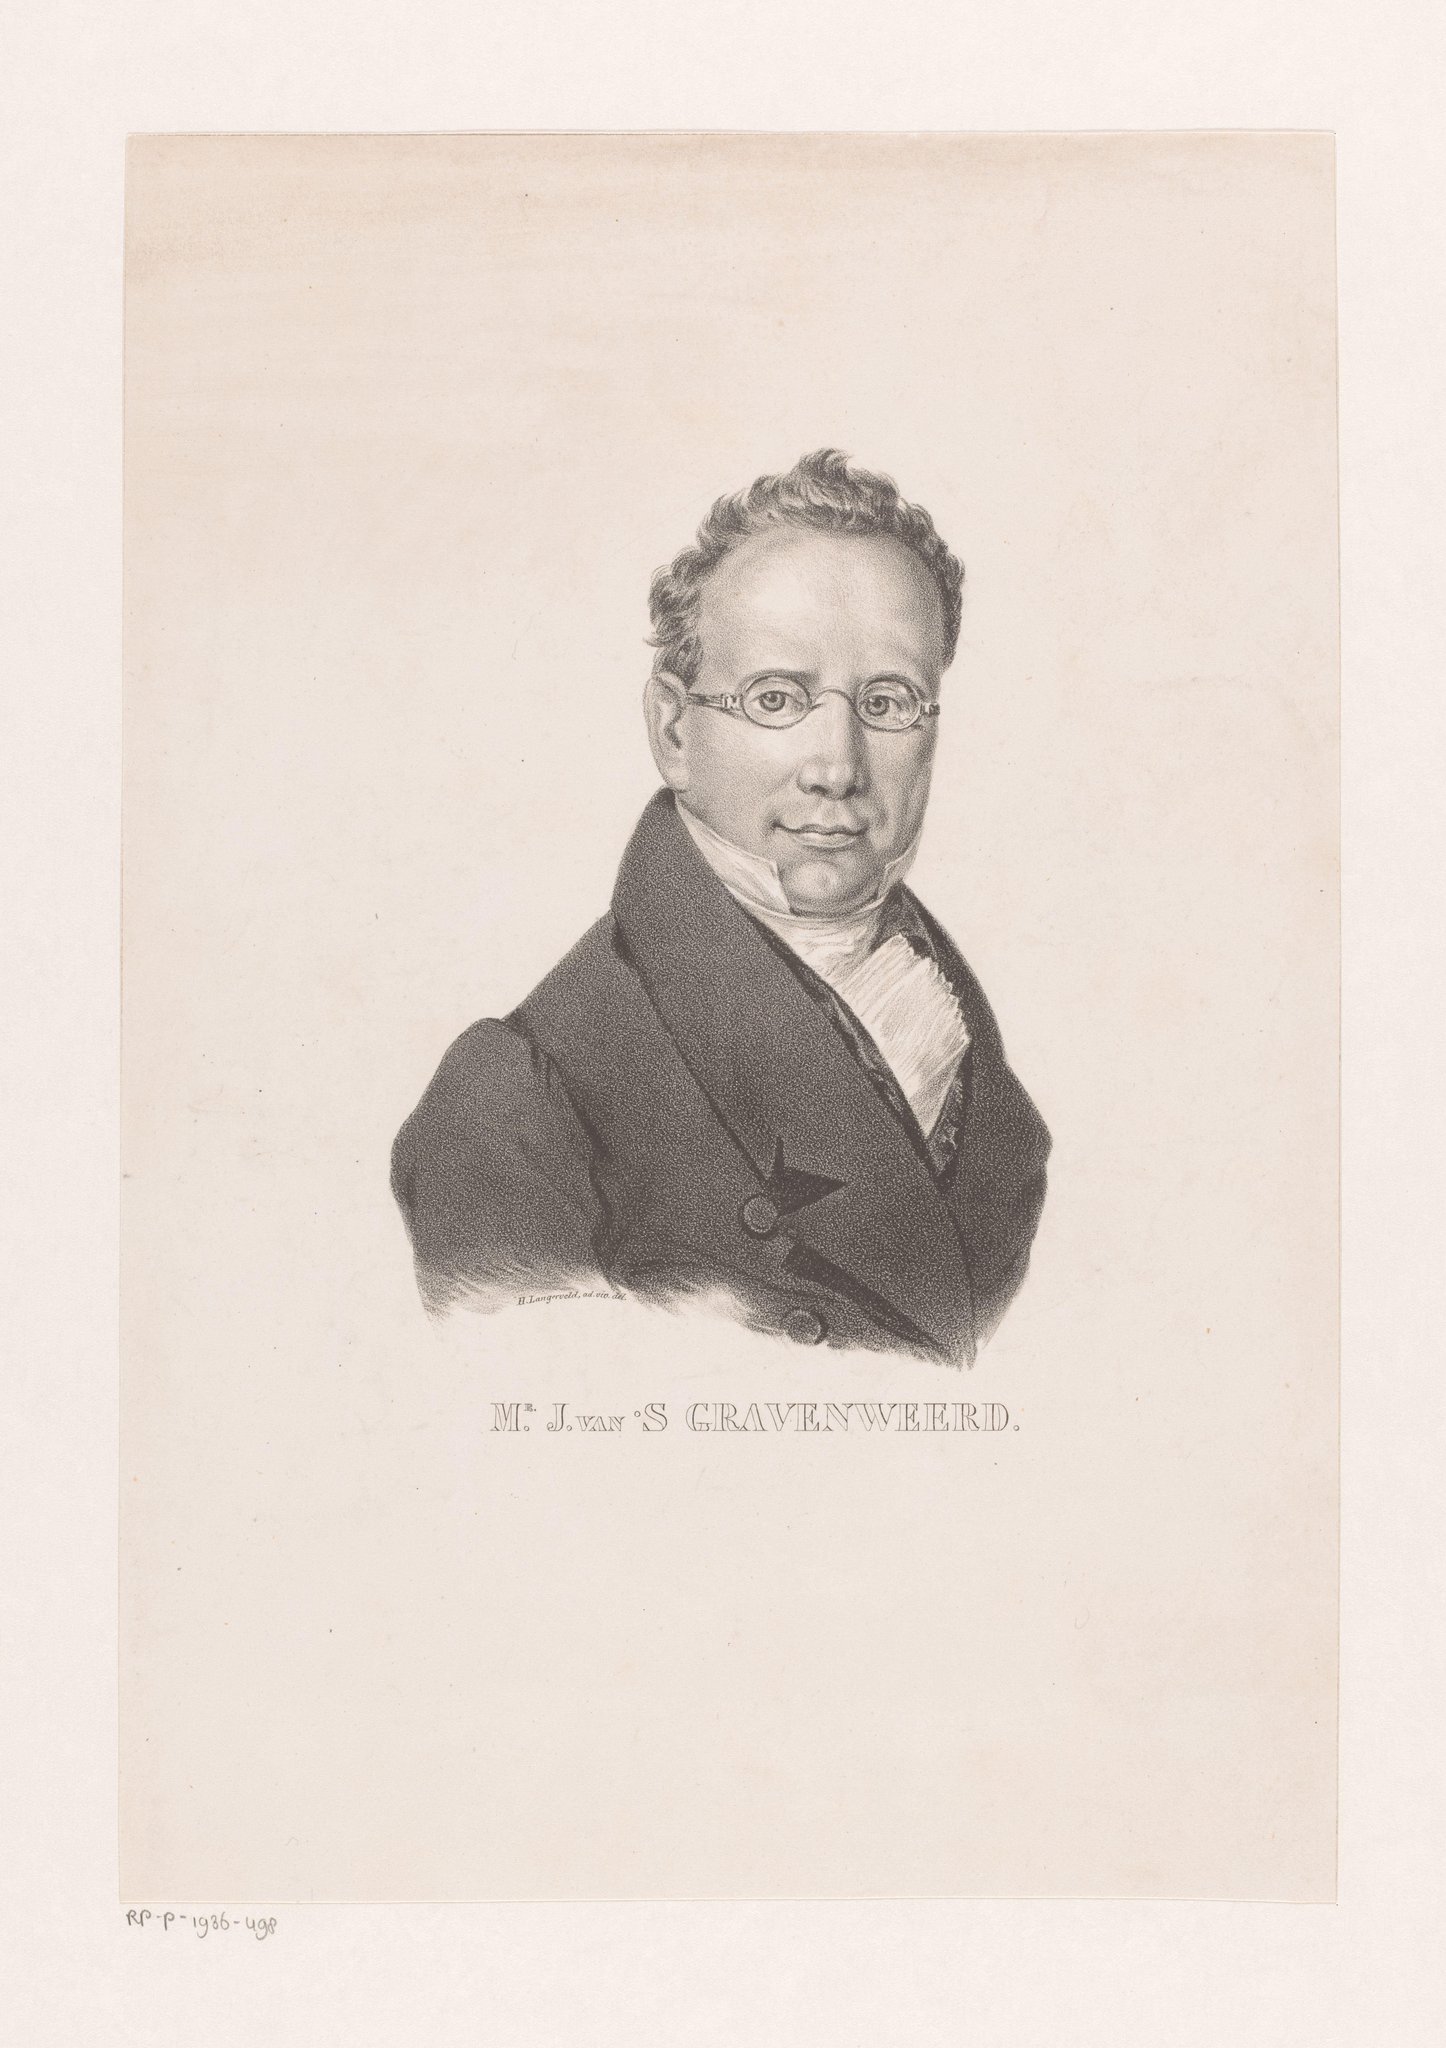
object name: print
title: Portret van Jan van 's-Gravenweerd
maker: harmanus langerveld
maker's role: print maker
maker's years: 1777-1830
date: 1820-1830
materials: paper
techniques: lithograph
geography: netherlands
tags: amsterdam, eyeglasses, spectacles, historical persons (+ (full) bust portrait)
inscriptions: collector's mark: Lugt 2760, collector's mark: Lugt 2228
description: De geportretteerde draagt een bril. Onder het portret zijn naam.